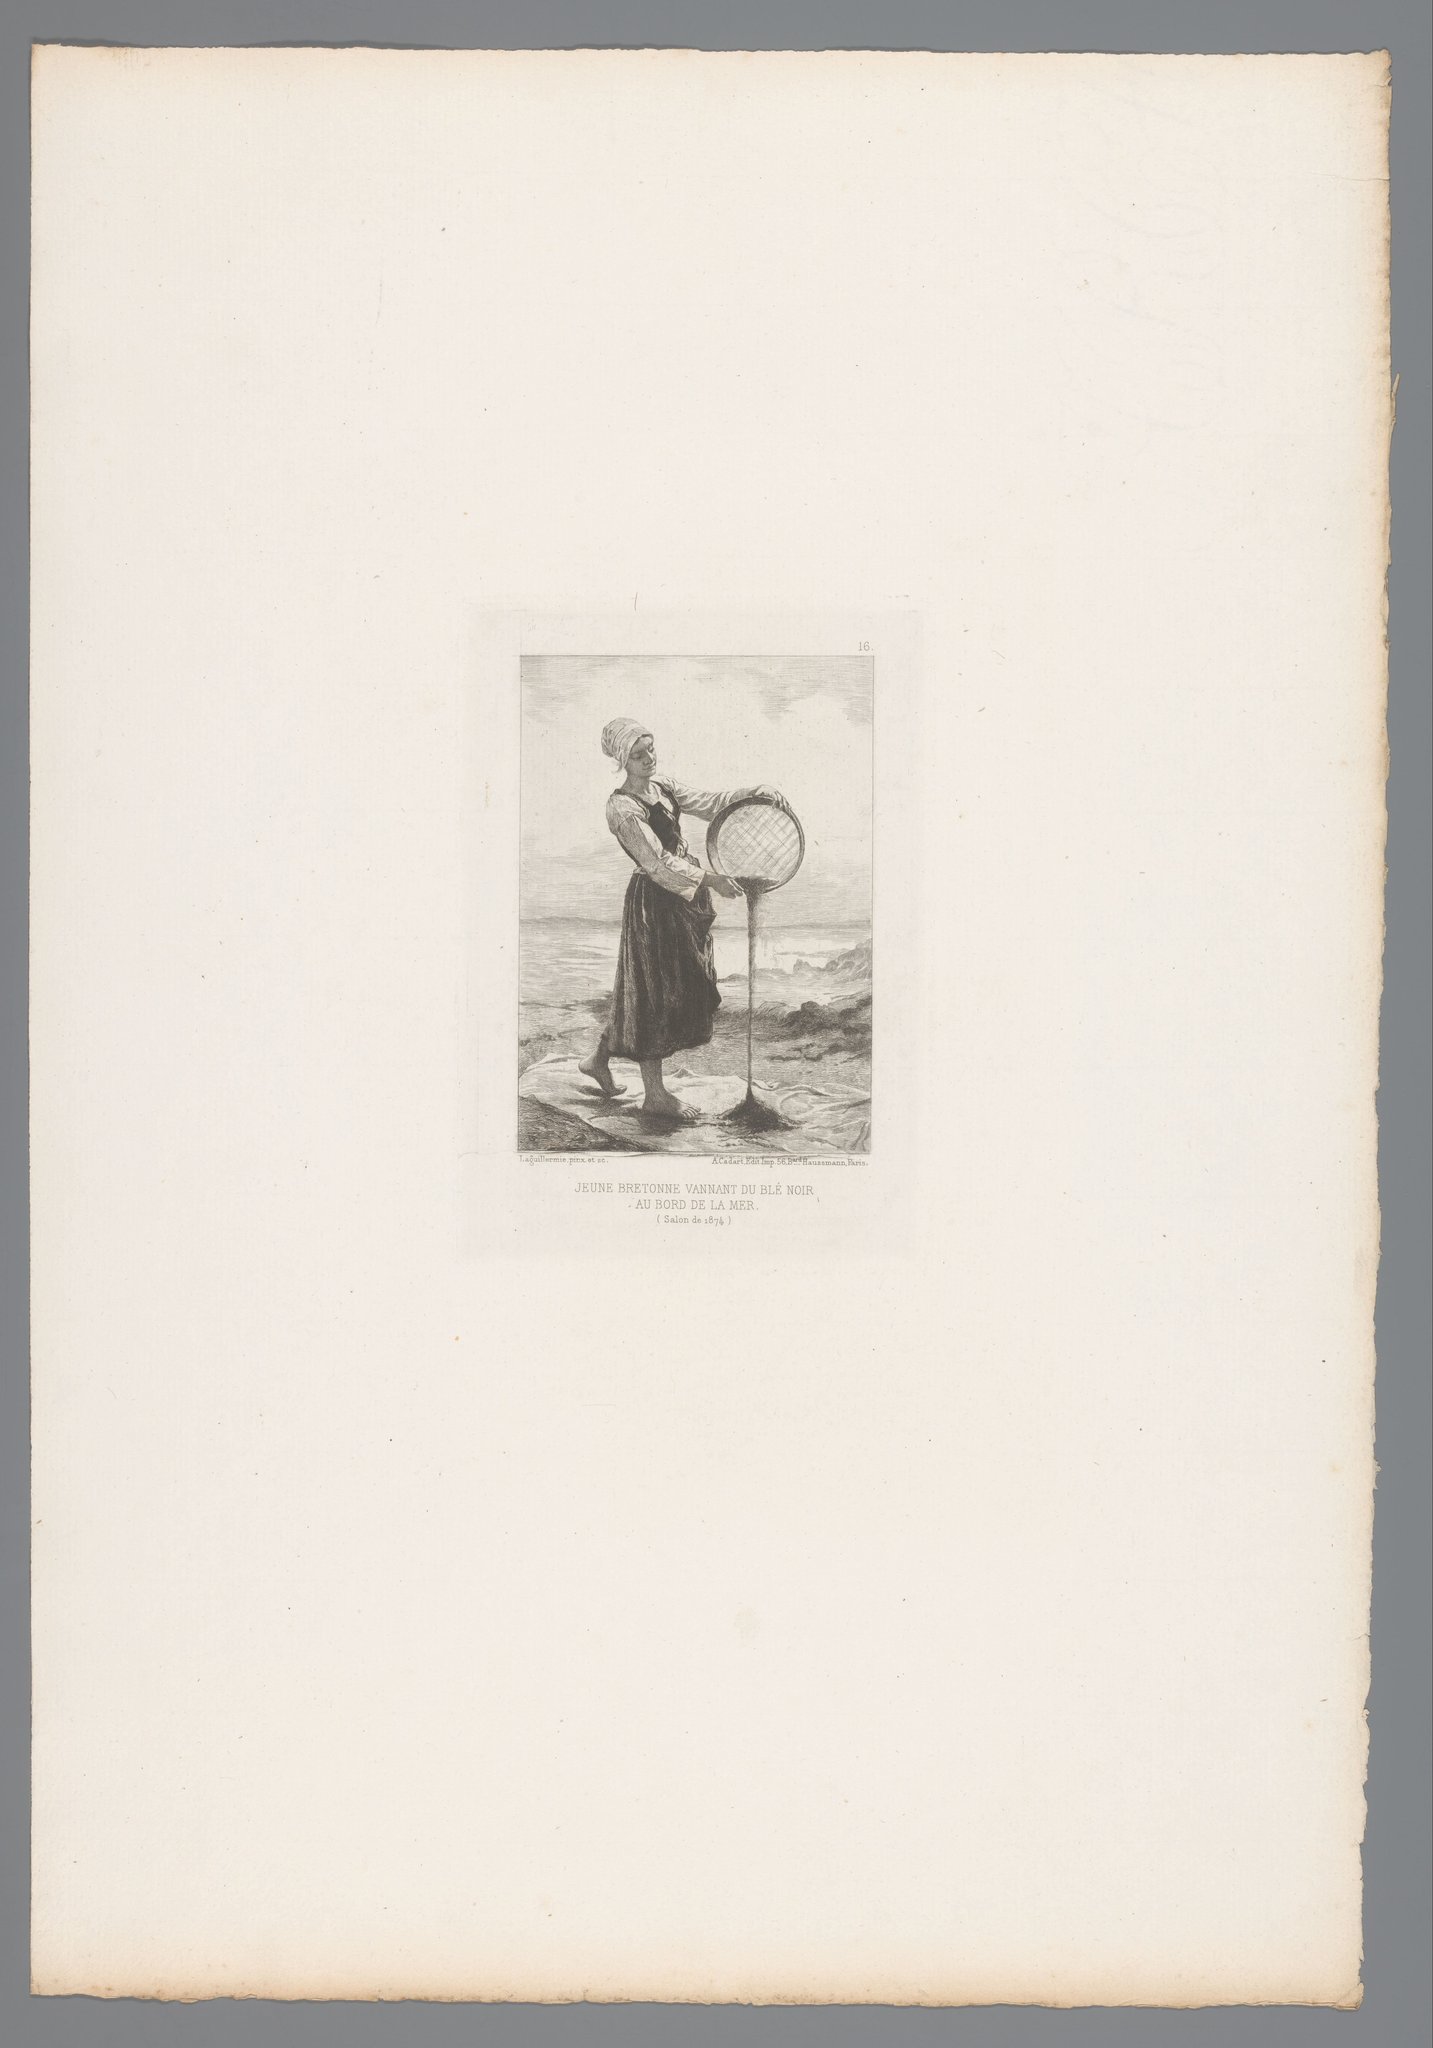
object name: print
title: Jeune Bretonne vannant du blé noir au bord de la mer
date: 1875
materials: paper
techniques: drypoint, etching, intaglio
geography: paris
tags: cereal, grain, corn (grass with grains, grown for food, e.g.: wheat, rice, rye, oats, maize, buckwheat, millet) (+ agricultural processes), sorting, selecting of material by sieving, sifting, screening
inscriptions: collector's mark: ‘AFE v S’, collector's mark: Lugt 2228, collector's mark: Lugt 2760, watermark